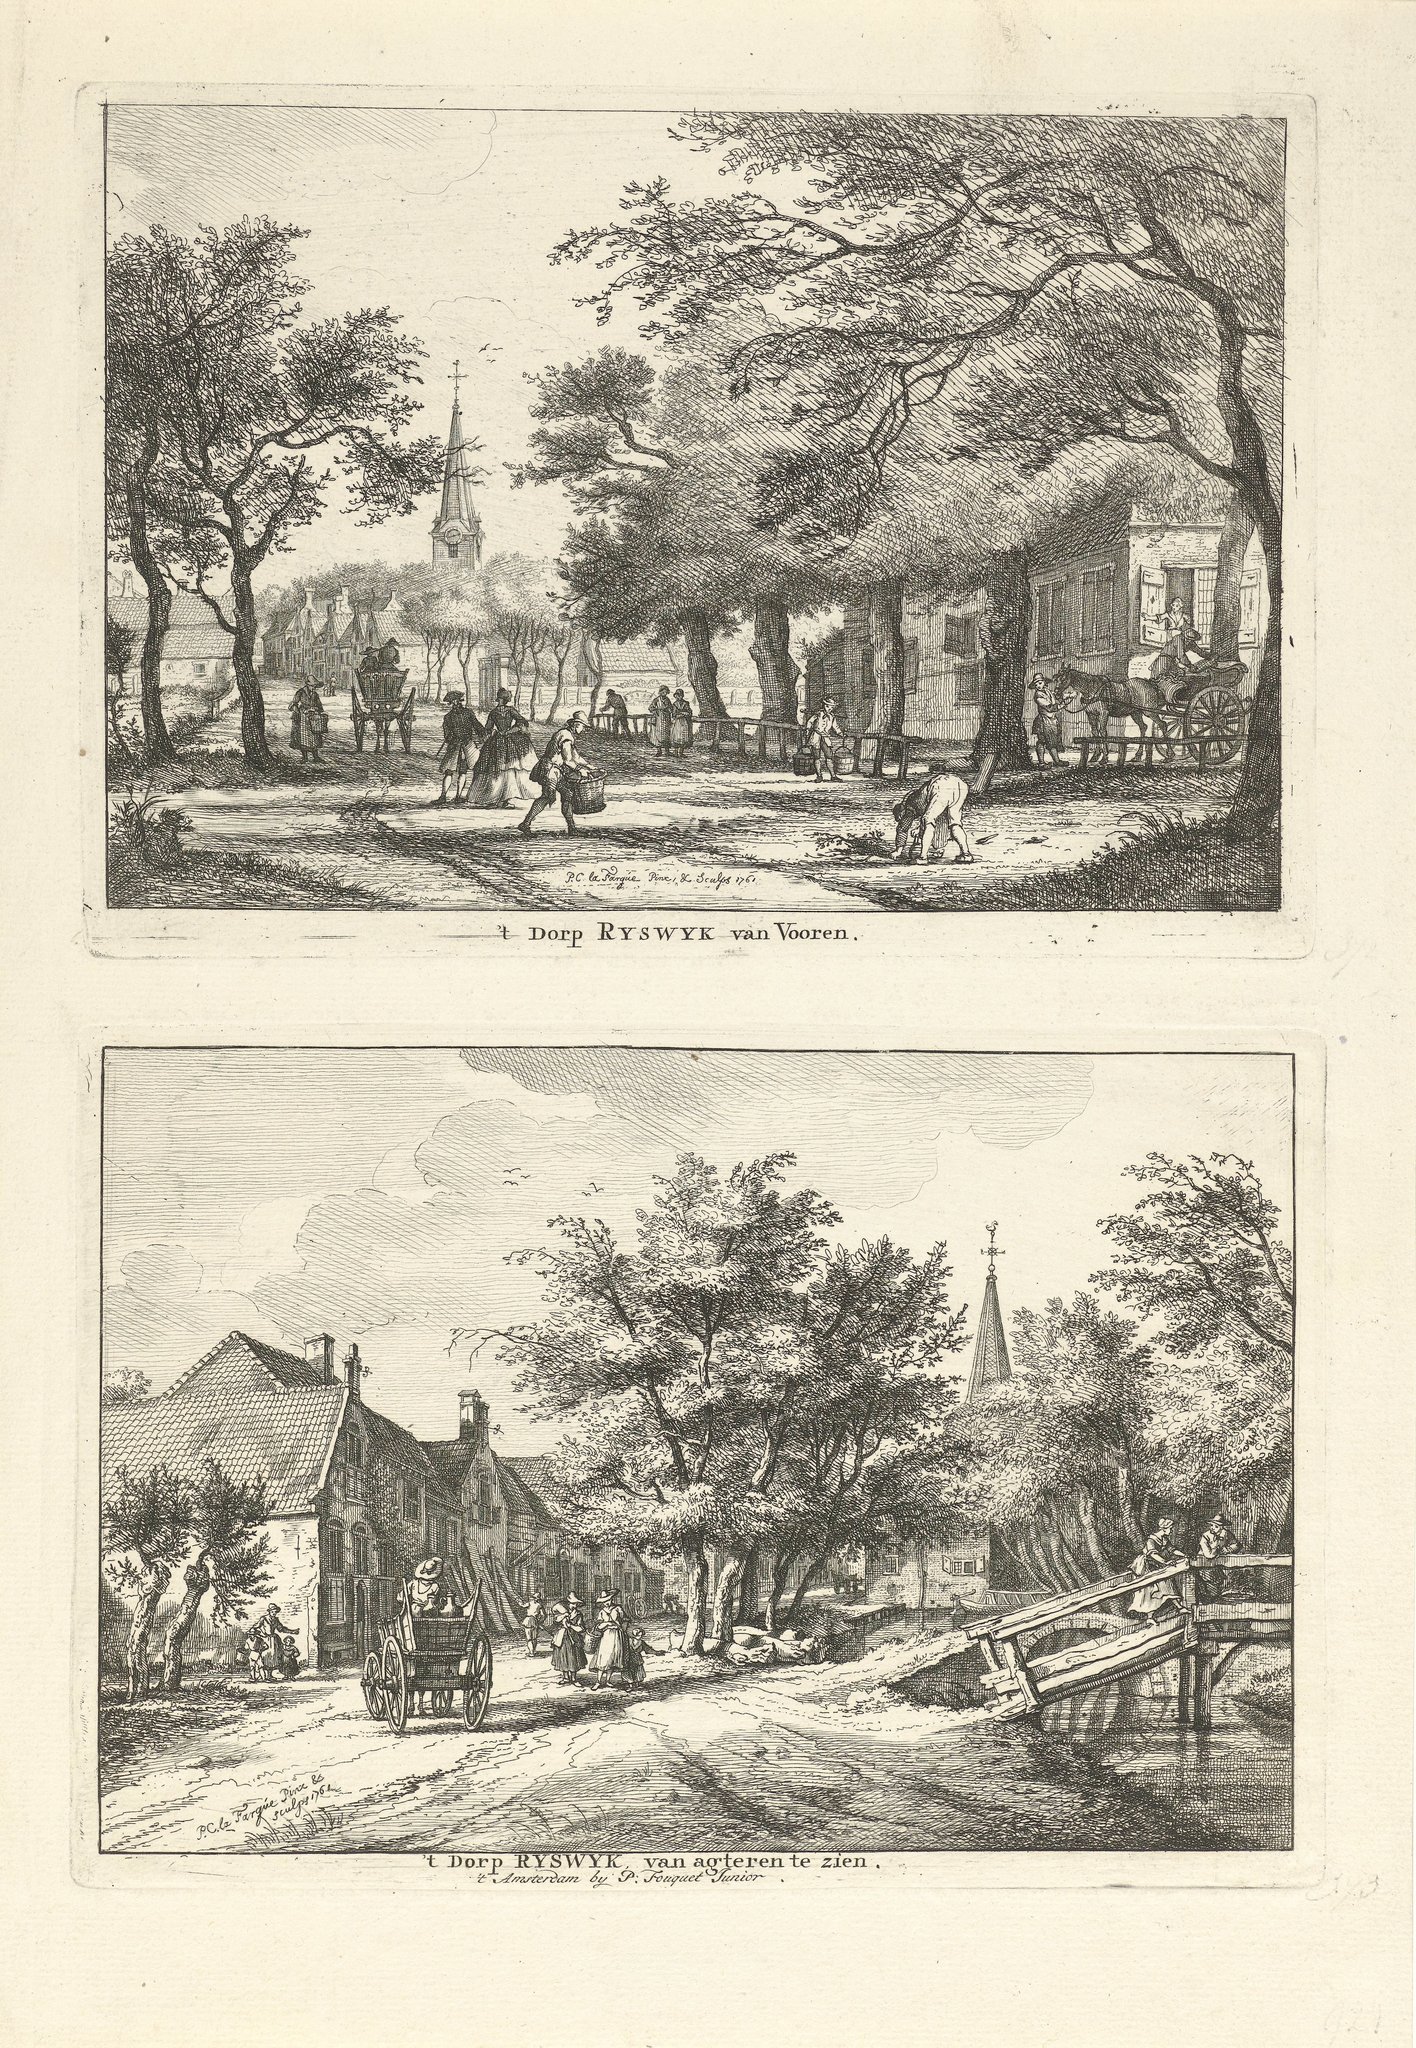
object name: print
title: 't Dorp Ryswyk van vooren / 't Dorp Ryswyk, van agteren te zien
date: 1761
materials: paper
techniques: engraving, etching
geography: amsterdam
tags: canals, waters (in village), village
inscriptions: collector's mark: Lugt 2228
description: Twee gezichten op het dorp Rijswijk, gedrukt van twee platen. Boven: Een dorpsstraat met figuren, in de verte een kerktoren. Onder: Een aan de vaart gelegen huizenrij waarlangs figuren wandelen. Uiterst rechts twee figuren op een brug, links een figuur op een kar. In de verte een kerktoren.